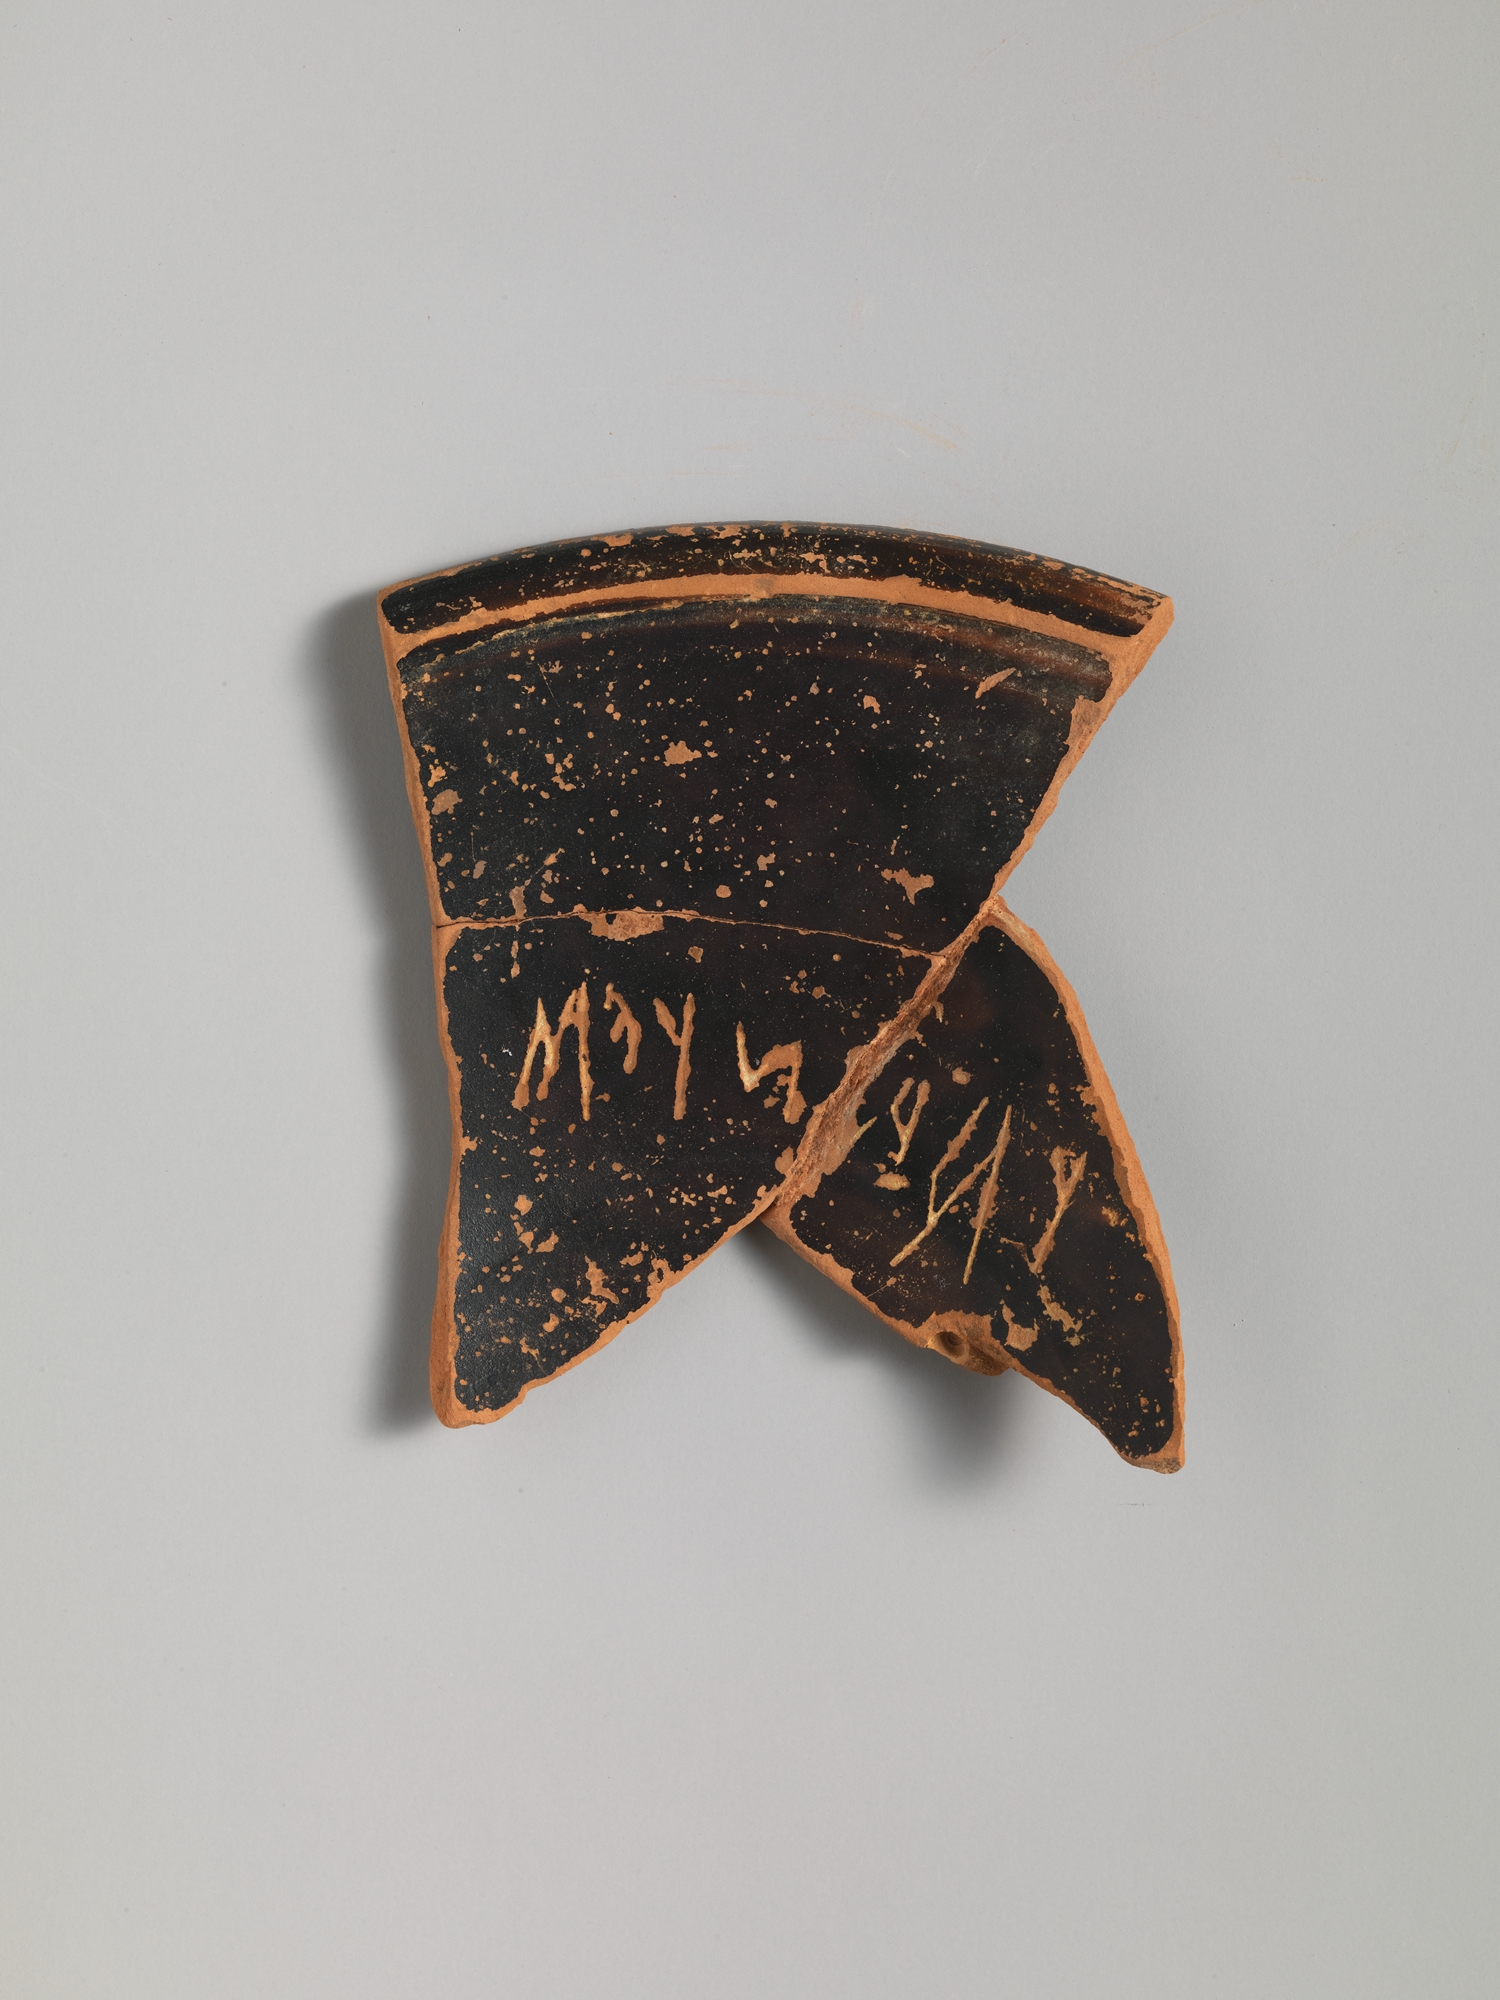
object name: vase, inscribed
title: Terracotta bowl fragments with graffito inscription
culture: etruscan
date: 300-201 BCE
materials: terracotta